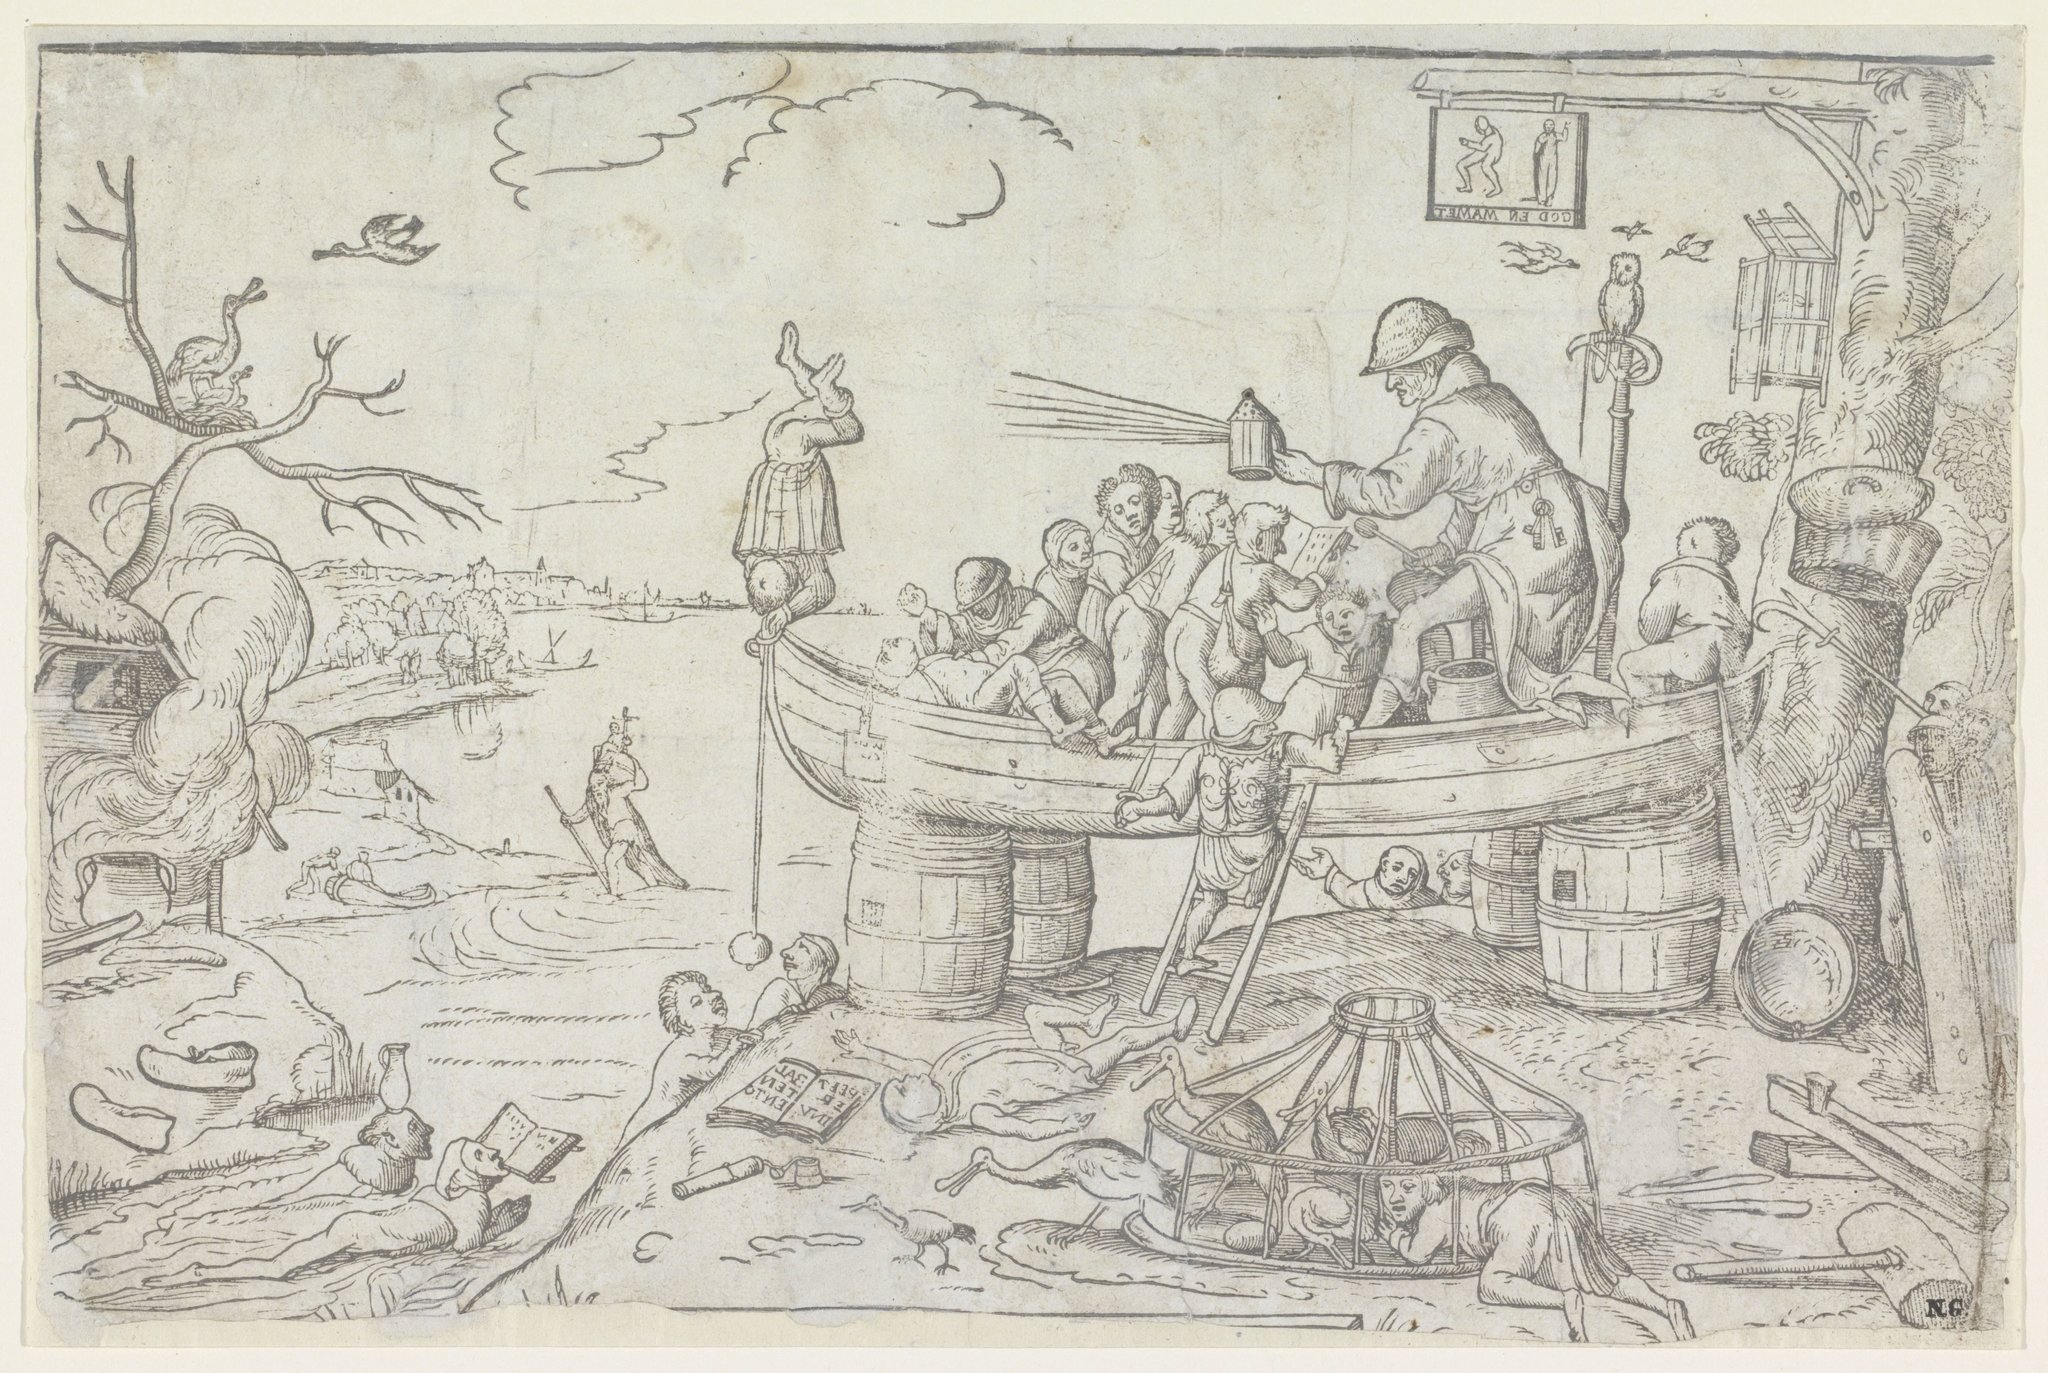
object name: print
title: Allegorie op de verkeerde wereld met de heilige Christoffel en het Christuskind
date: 1535-1584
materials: paper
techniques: woodcut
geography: netherlands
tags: lantern, scholastic education, tuition, the giant and martyr christophorus; possible attributes: palm-tree (with bunches of dates, or withered), infant christ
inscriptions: collector's mark: Lugt 2228, collector's mark: Lugt 1967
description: Christoffel draagt het Christuskind op zijn schouders de rivier over. Het kind houdt een wereldbol met een kruis vast. Op de oever van de rivier zit een schoolklas in een boot die op vier biertonnen staat. De schoolmeester schijnt met een lantaarn bij daglicht. Boven zijn hoofd hangt een uithangbord met twee figuren en de tekst 'GOD EN MAMET' (Mohammed?).